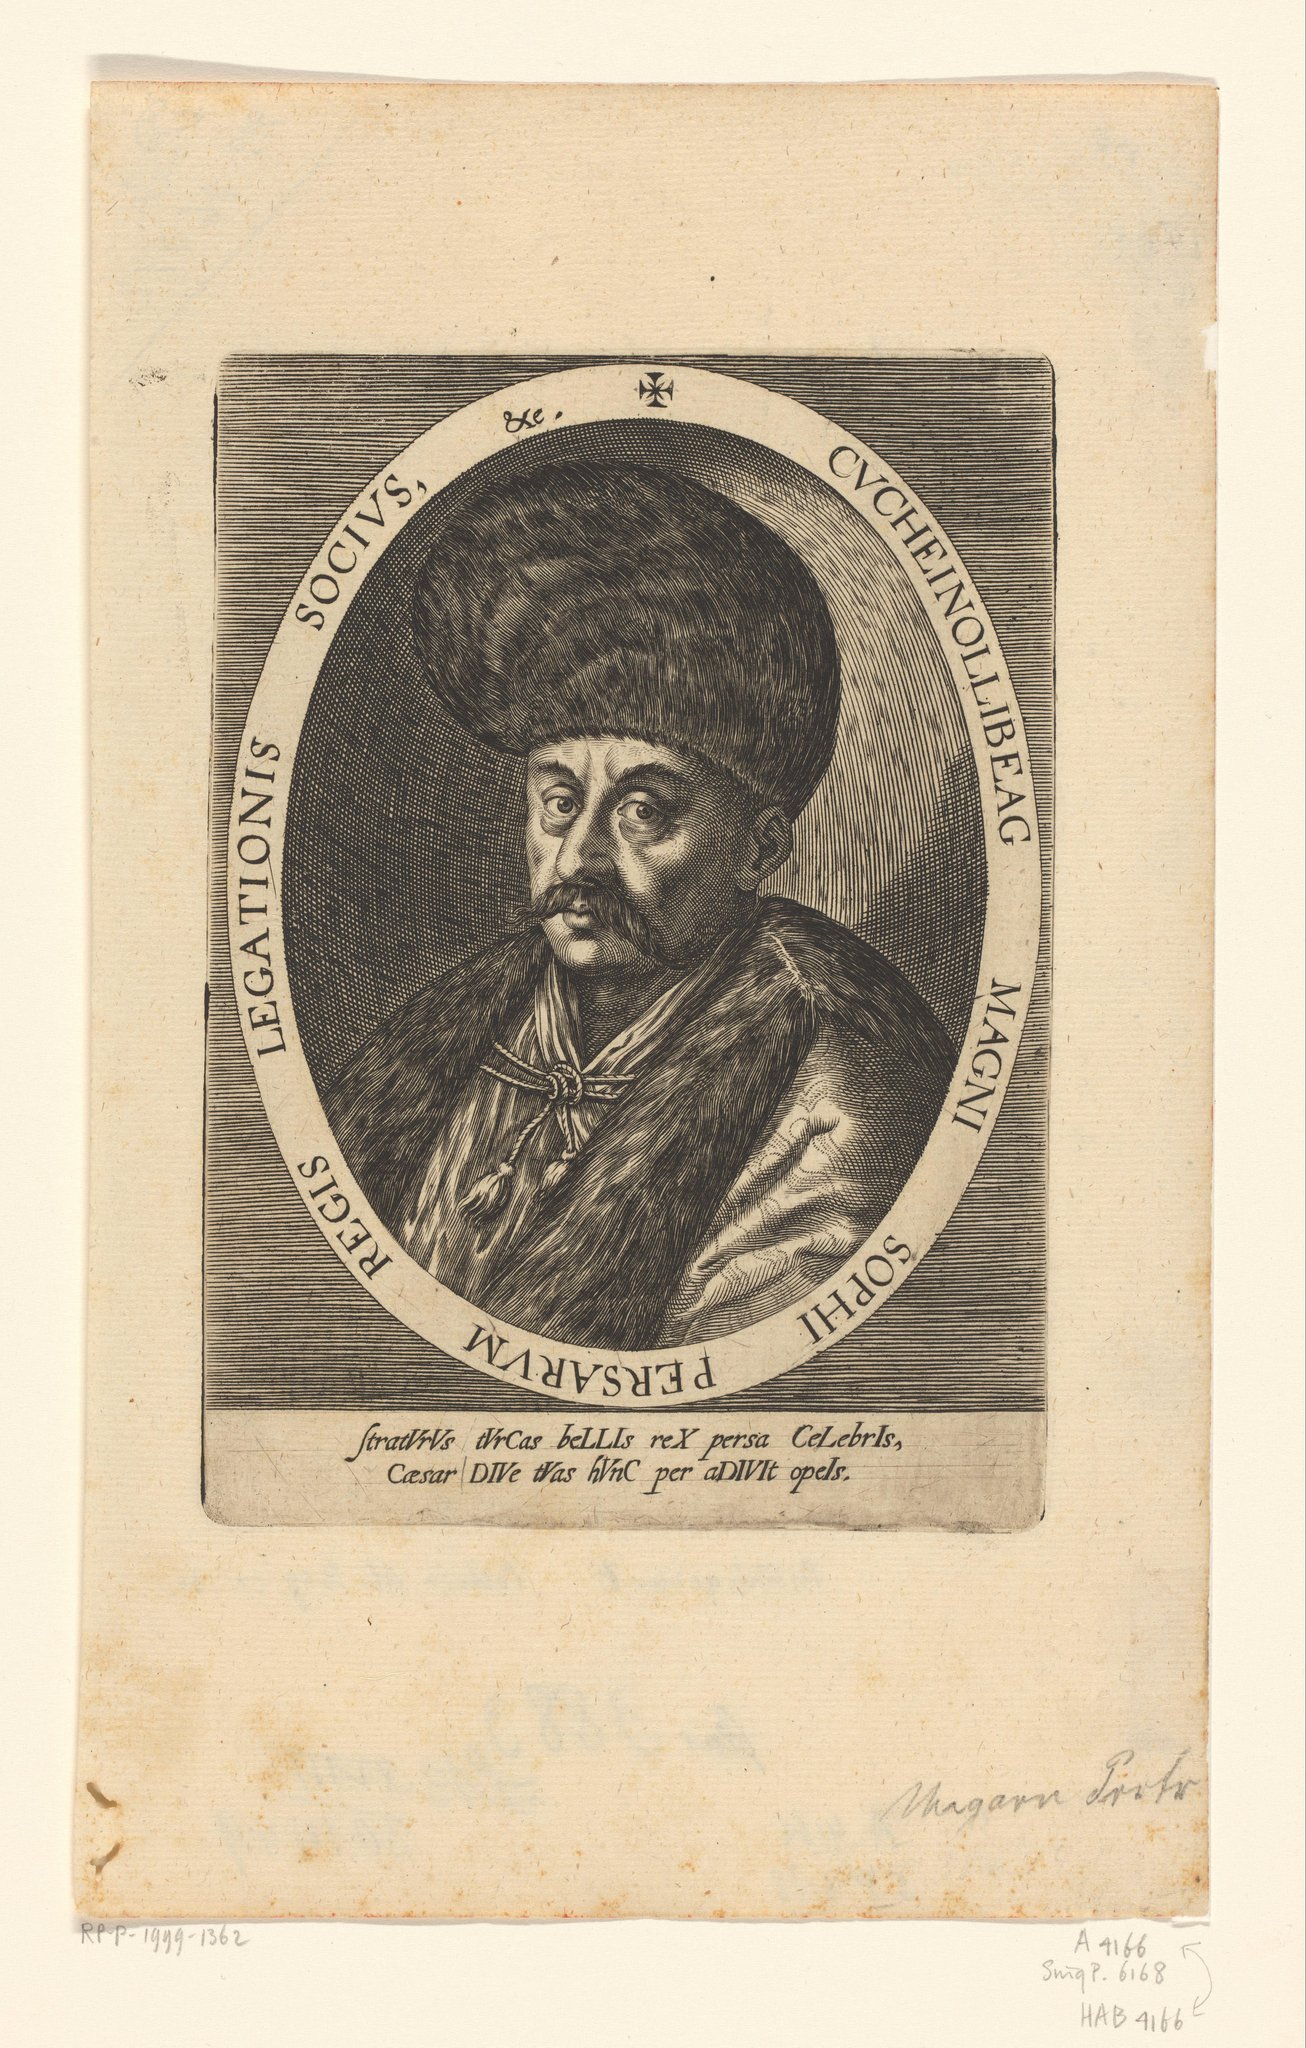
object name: print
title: Portret van Cuchein Ali Beg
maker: dominicus custos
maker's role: print maker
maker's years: 1560-1615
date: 1601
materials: paper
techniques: engraving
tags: historical persons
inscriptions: collector's mark: Lugt 2228, collector's mark: Lugt 2760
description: Prent met tekst op recto gebruikt in: Atrium Heroicum. Augsburg: Dominicus Custos, 1601, dl. 3.